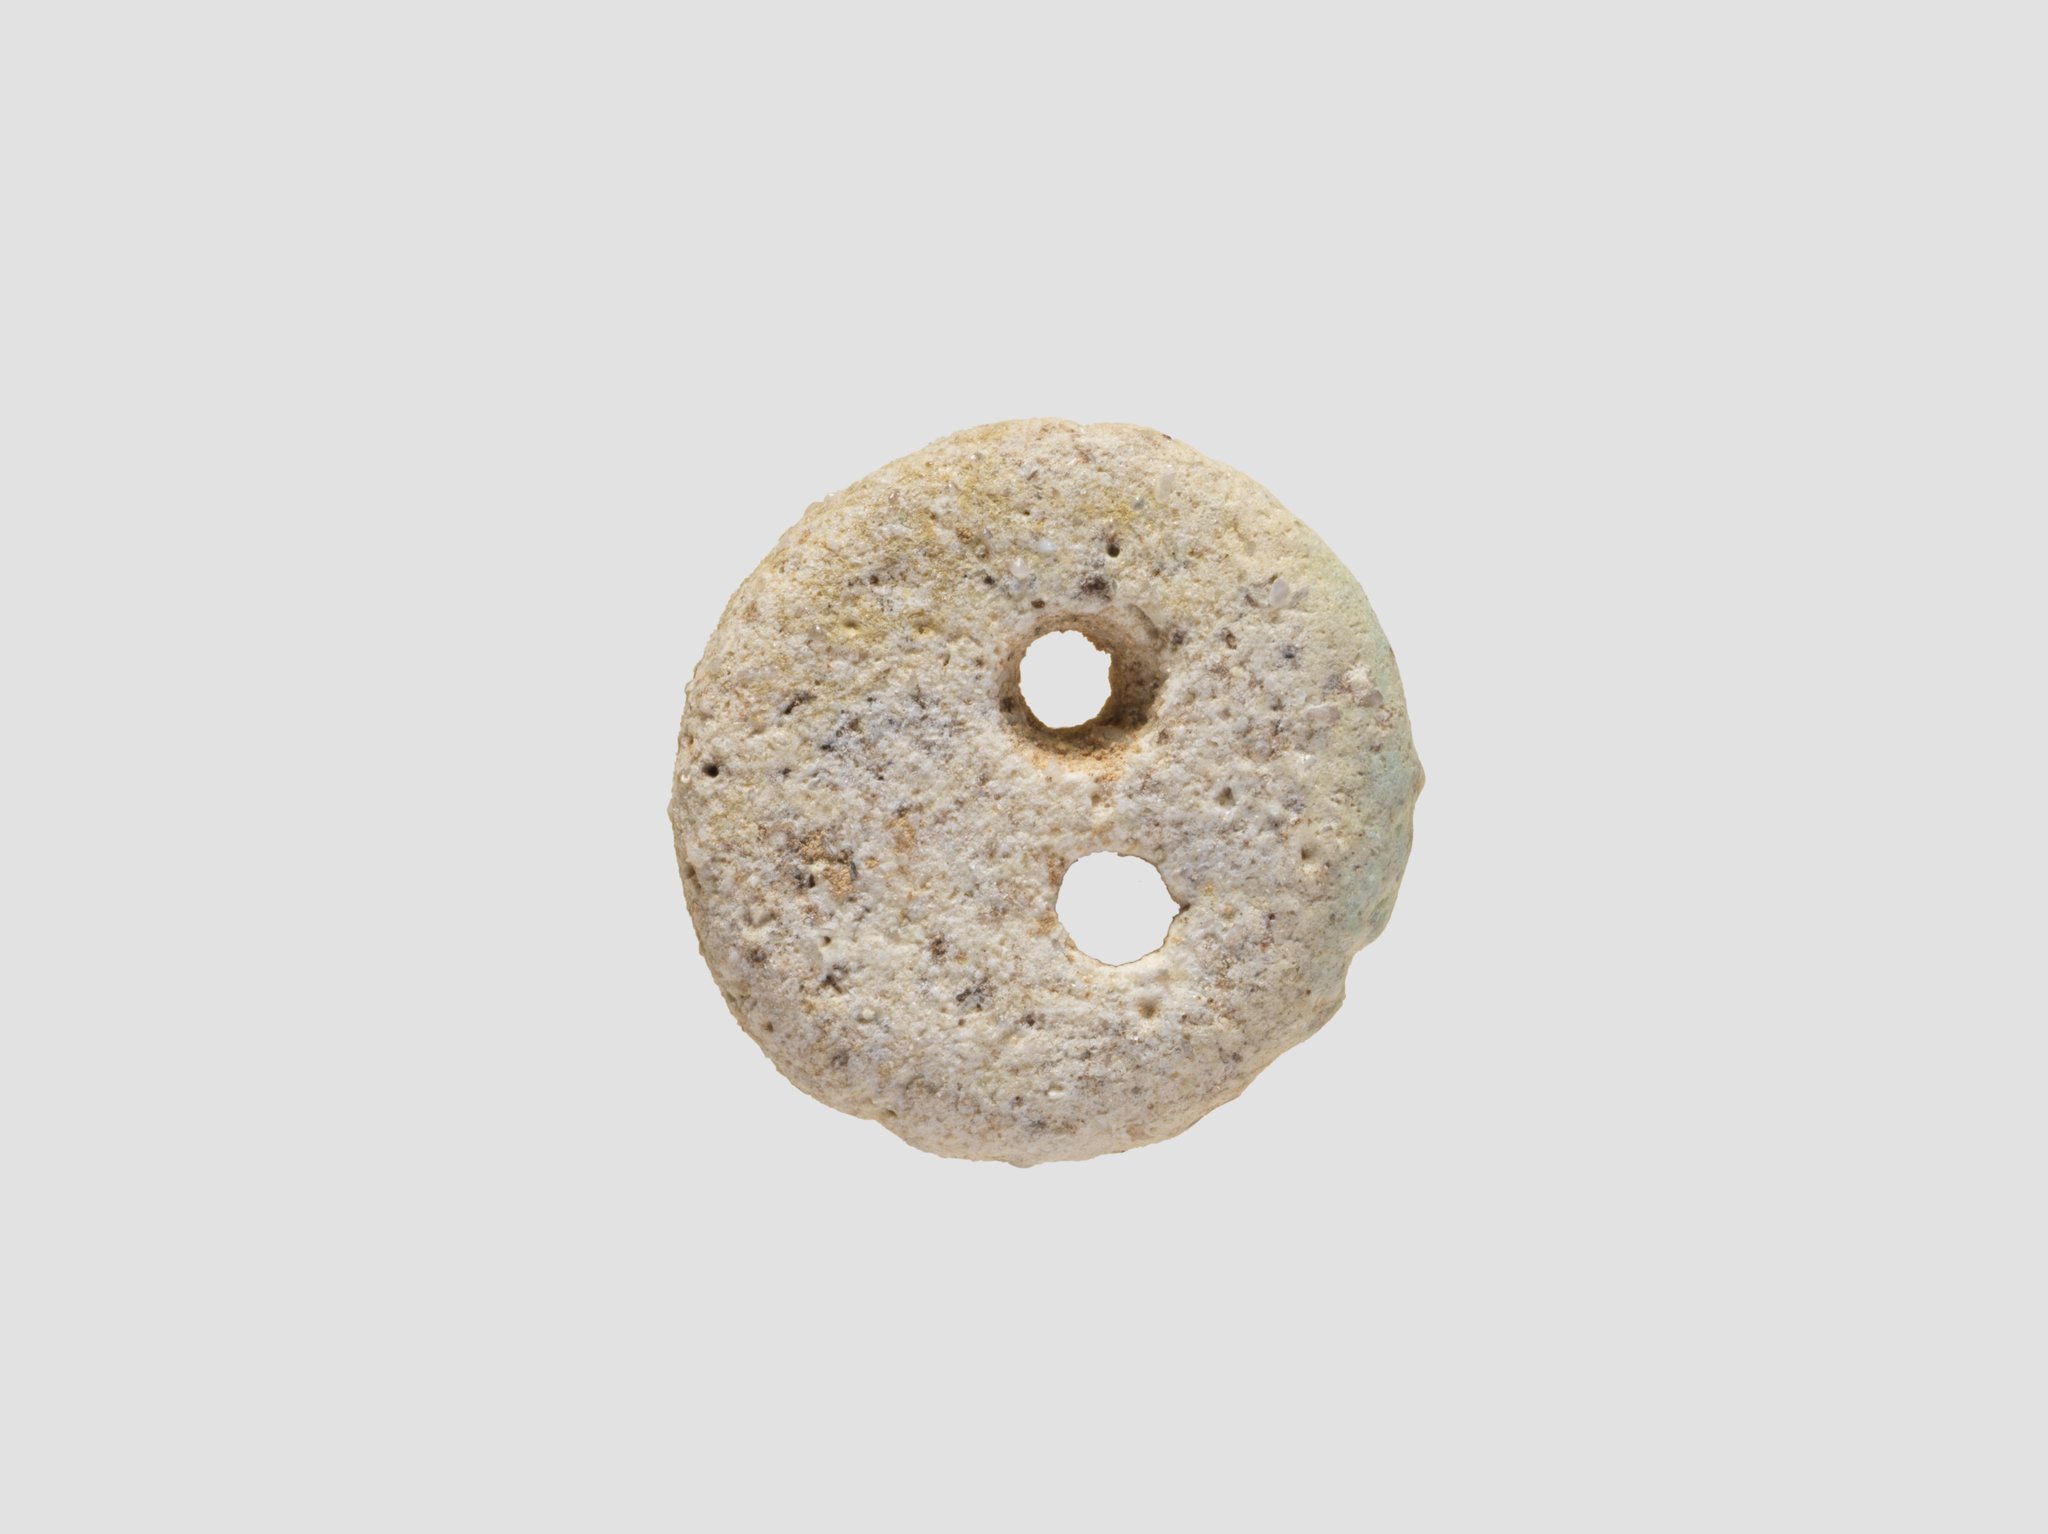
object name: ornament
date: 2333-2001 BCE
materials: faience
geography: mesopotamia